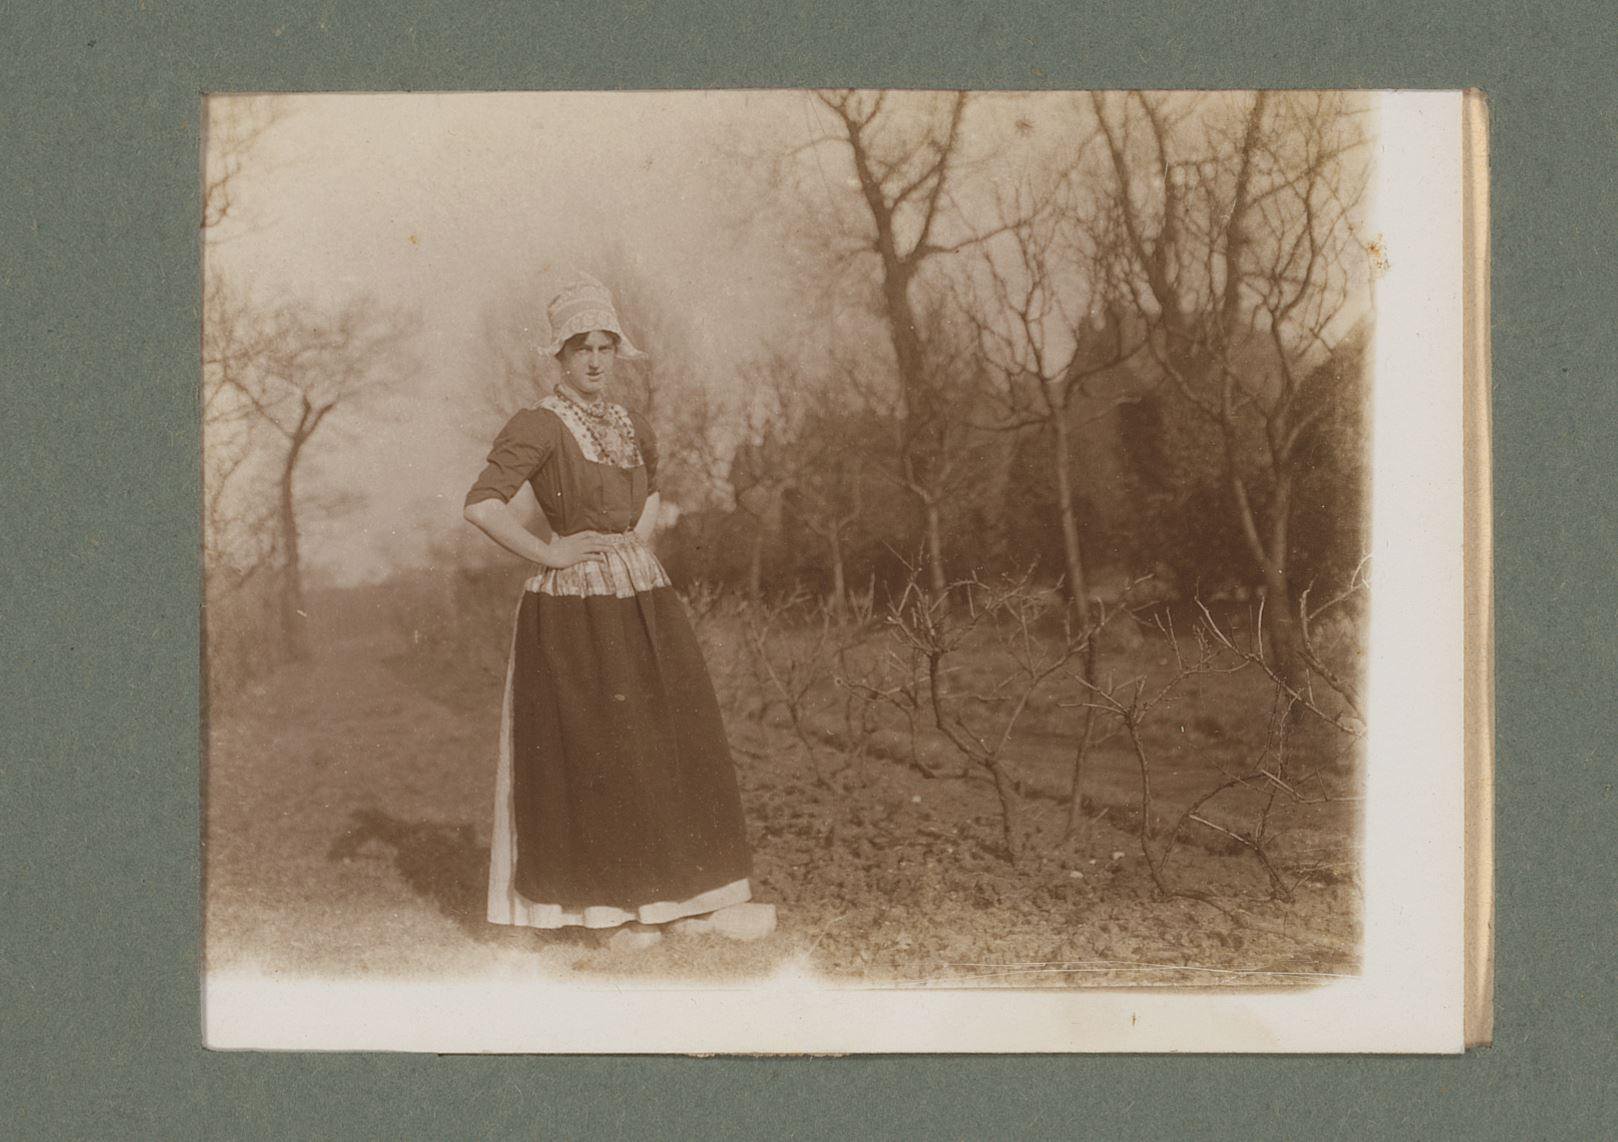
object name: album leaf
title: Vrouw in klederdracht, staande tussen kale bomen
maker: george hidderley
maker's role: fotograaf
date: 1920-1940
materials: photographic support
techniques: collodion silver print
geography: netherlands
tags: trees, historical persons - bb - woman, folk costume, regional costume